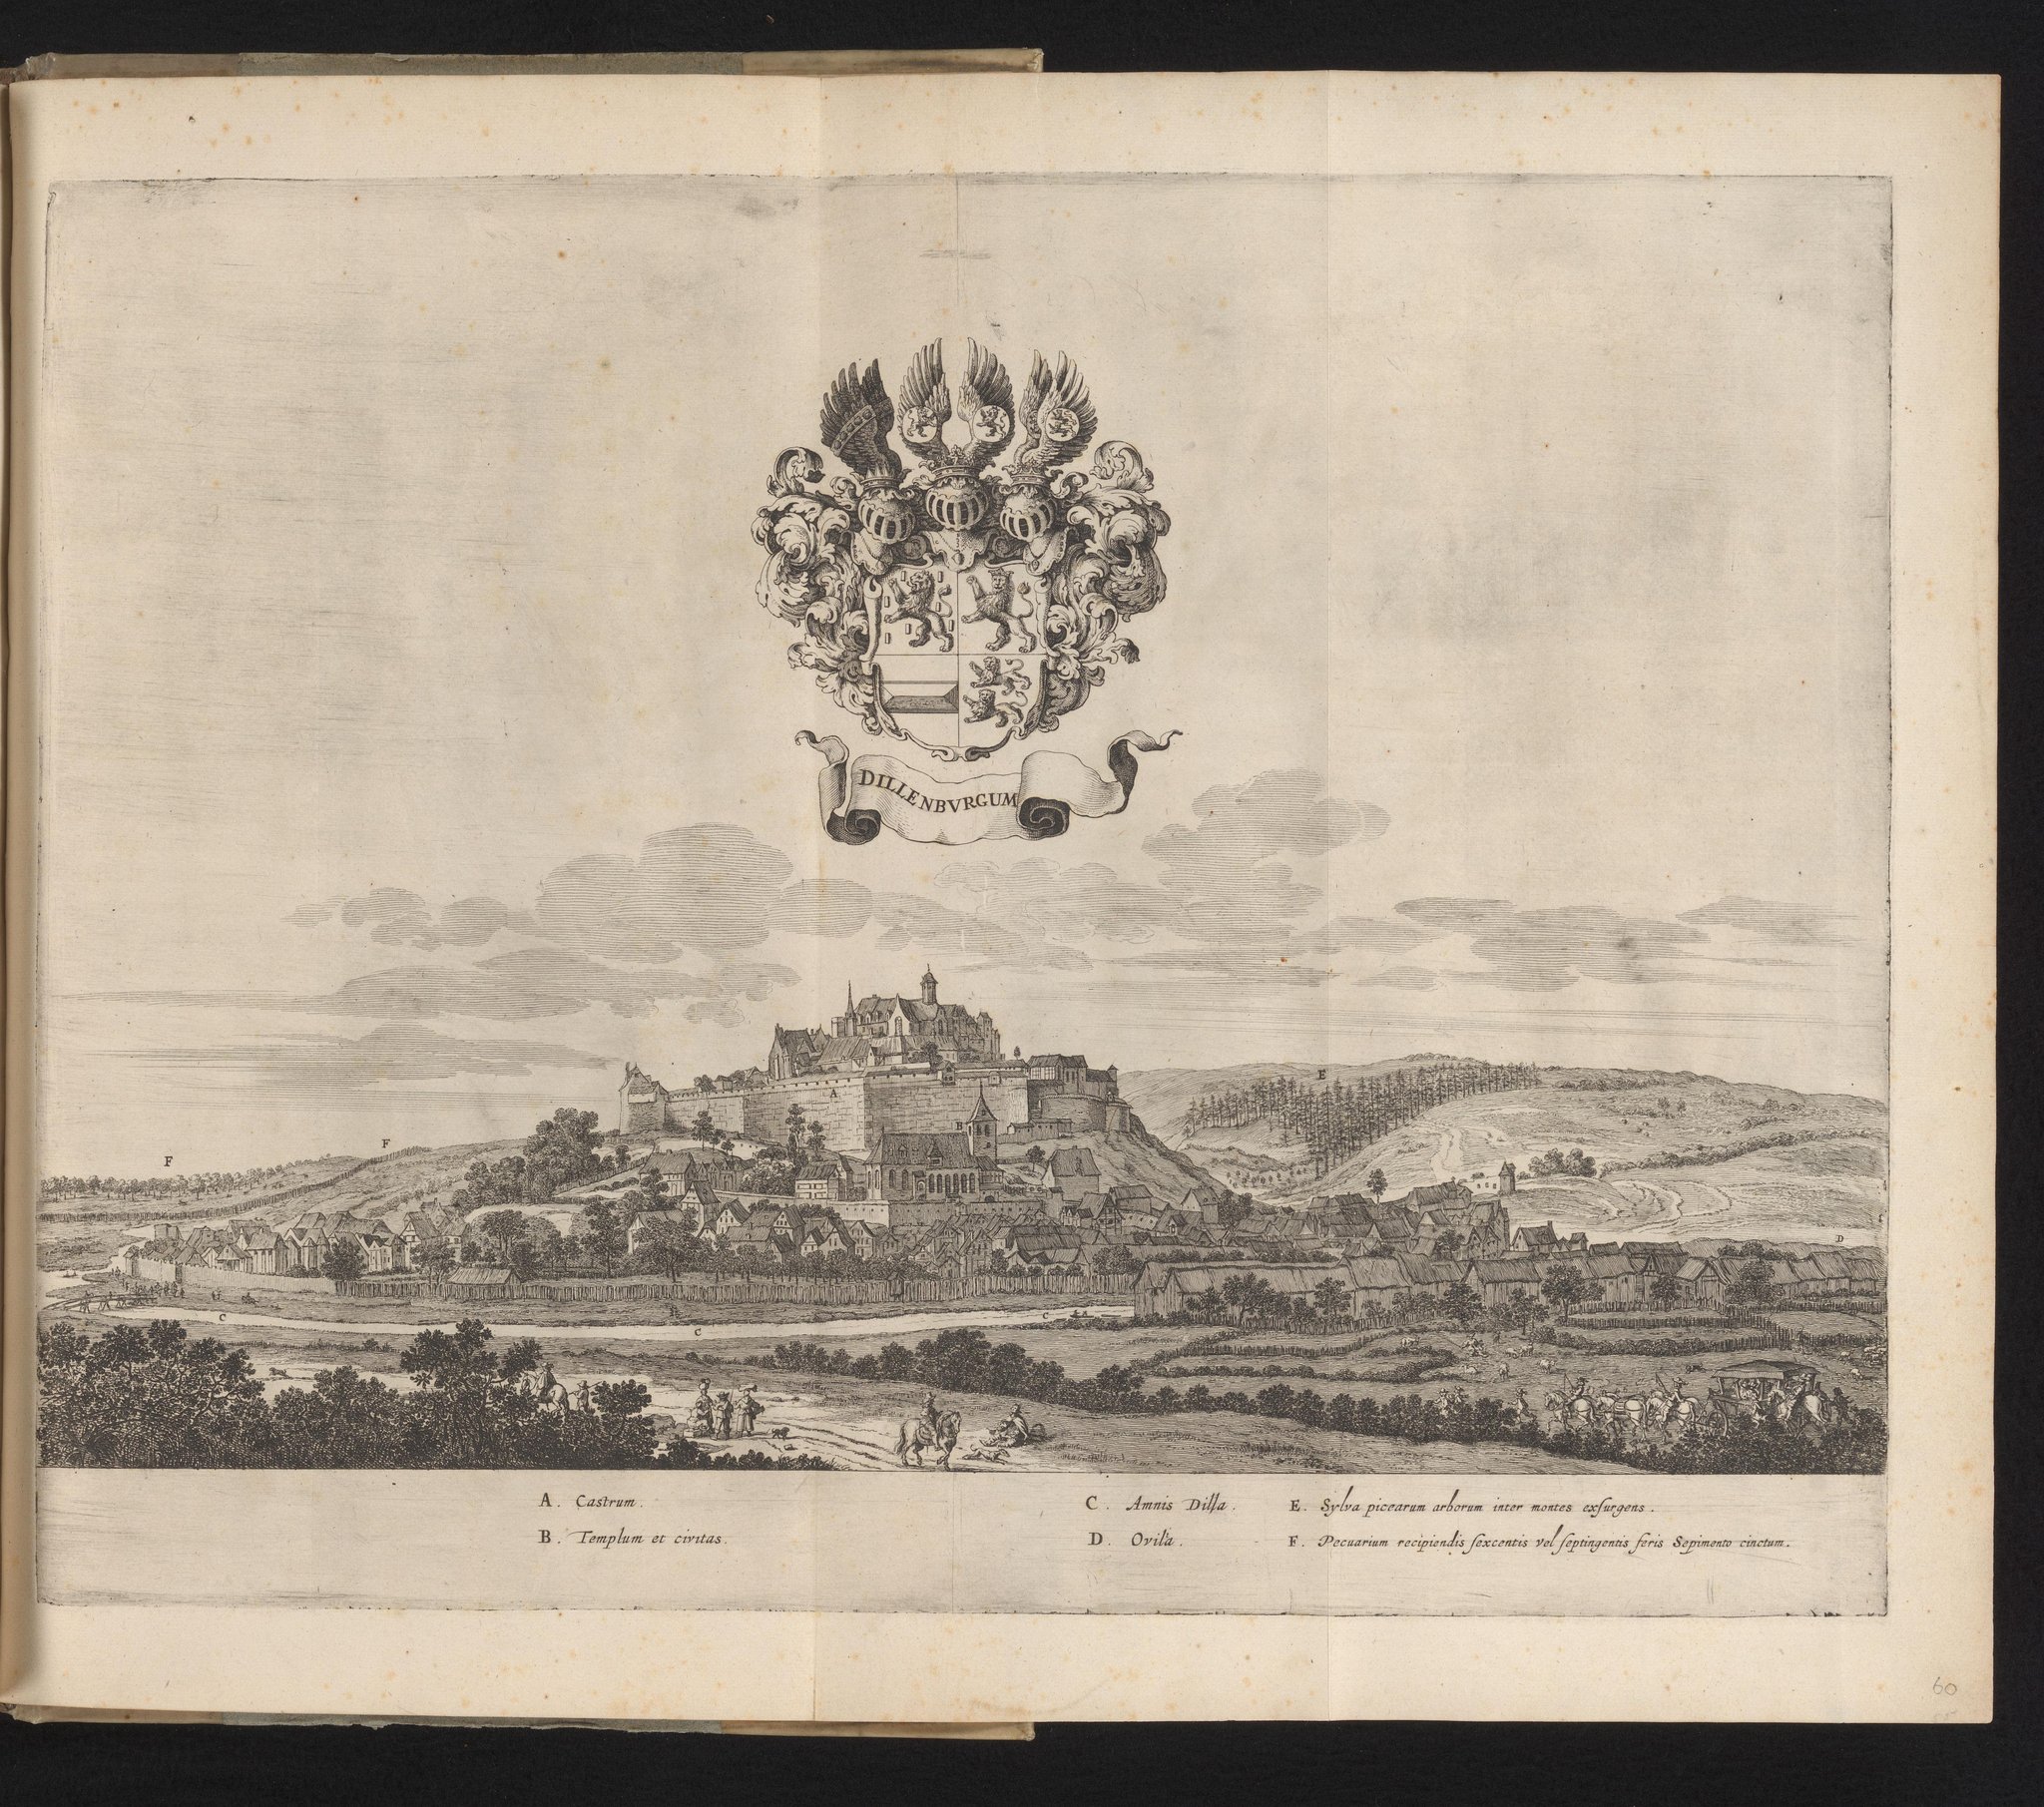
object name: print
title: Dillenburgum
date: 1645-1647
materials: paper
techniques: etching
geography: amsterdam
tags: johan maurits graaf van nassau-siegen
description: Gezicht op Slot Dillenburg, ca. 1645. Boven het kasteel het wapen van Dillenburg, de geboorteplaats van Johan Maurits. In het onderschrift de verklaring van de letters A-F in het Latijn. Plaat [nr. 55] in een serie van 55 voorstellingen van de tocht naar en het verblijf in Brazilië van graaf Johan Maurits van Nassau in de jaren 1636-1644.